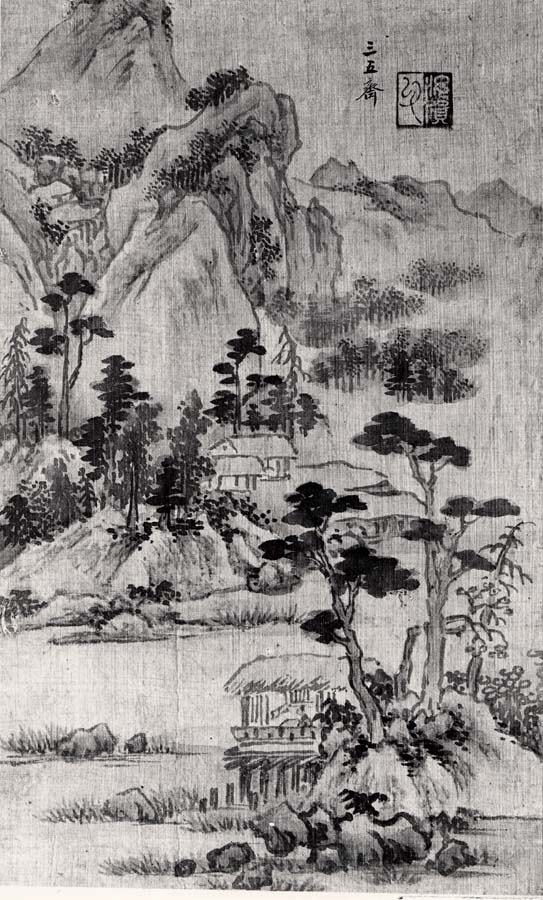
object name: painting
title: Scholar in a Lakeside Pavilion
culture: korean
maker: samoje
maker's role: artist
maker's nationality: korean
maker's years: 1771-1779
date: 1767-1800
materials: hemp, ink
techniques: painting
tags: mountains,landscapes,pavilions